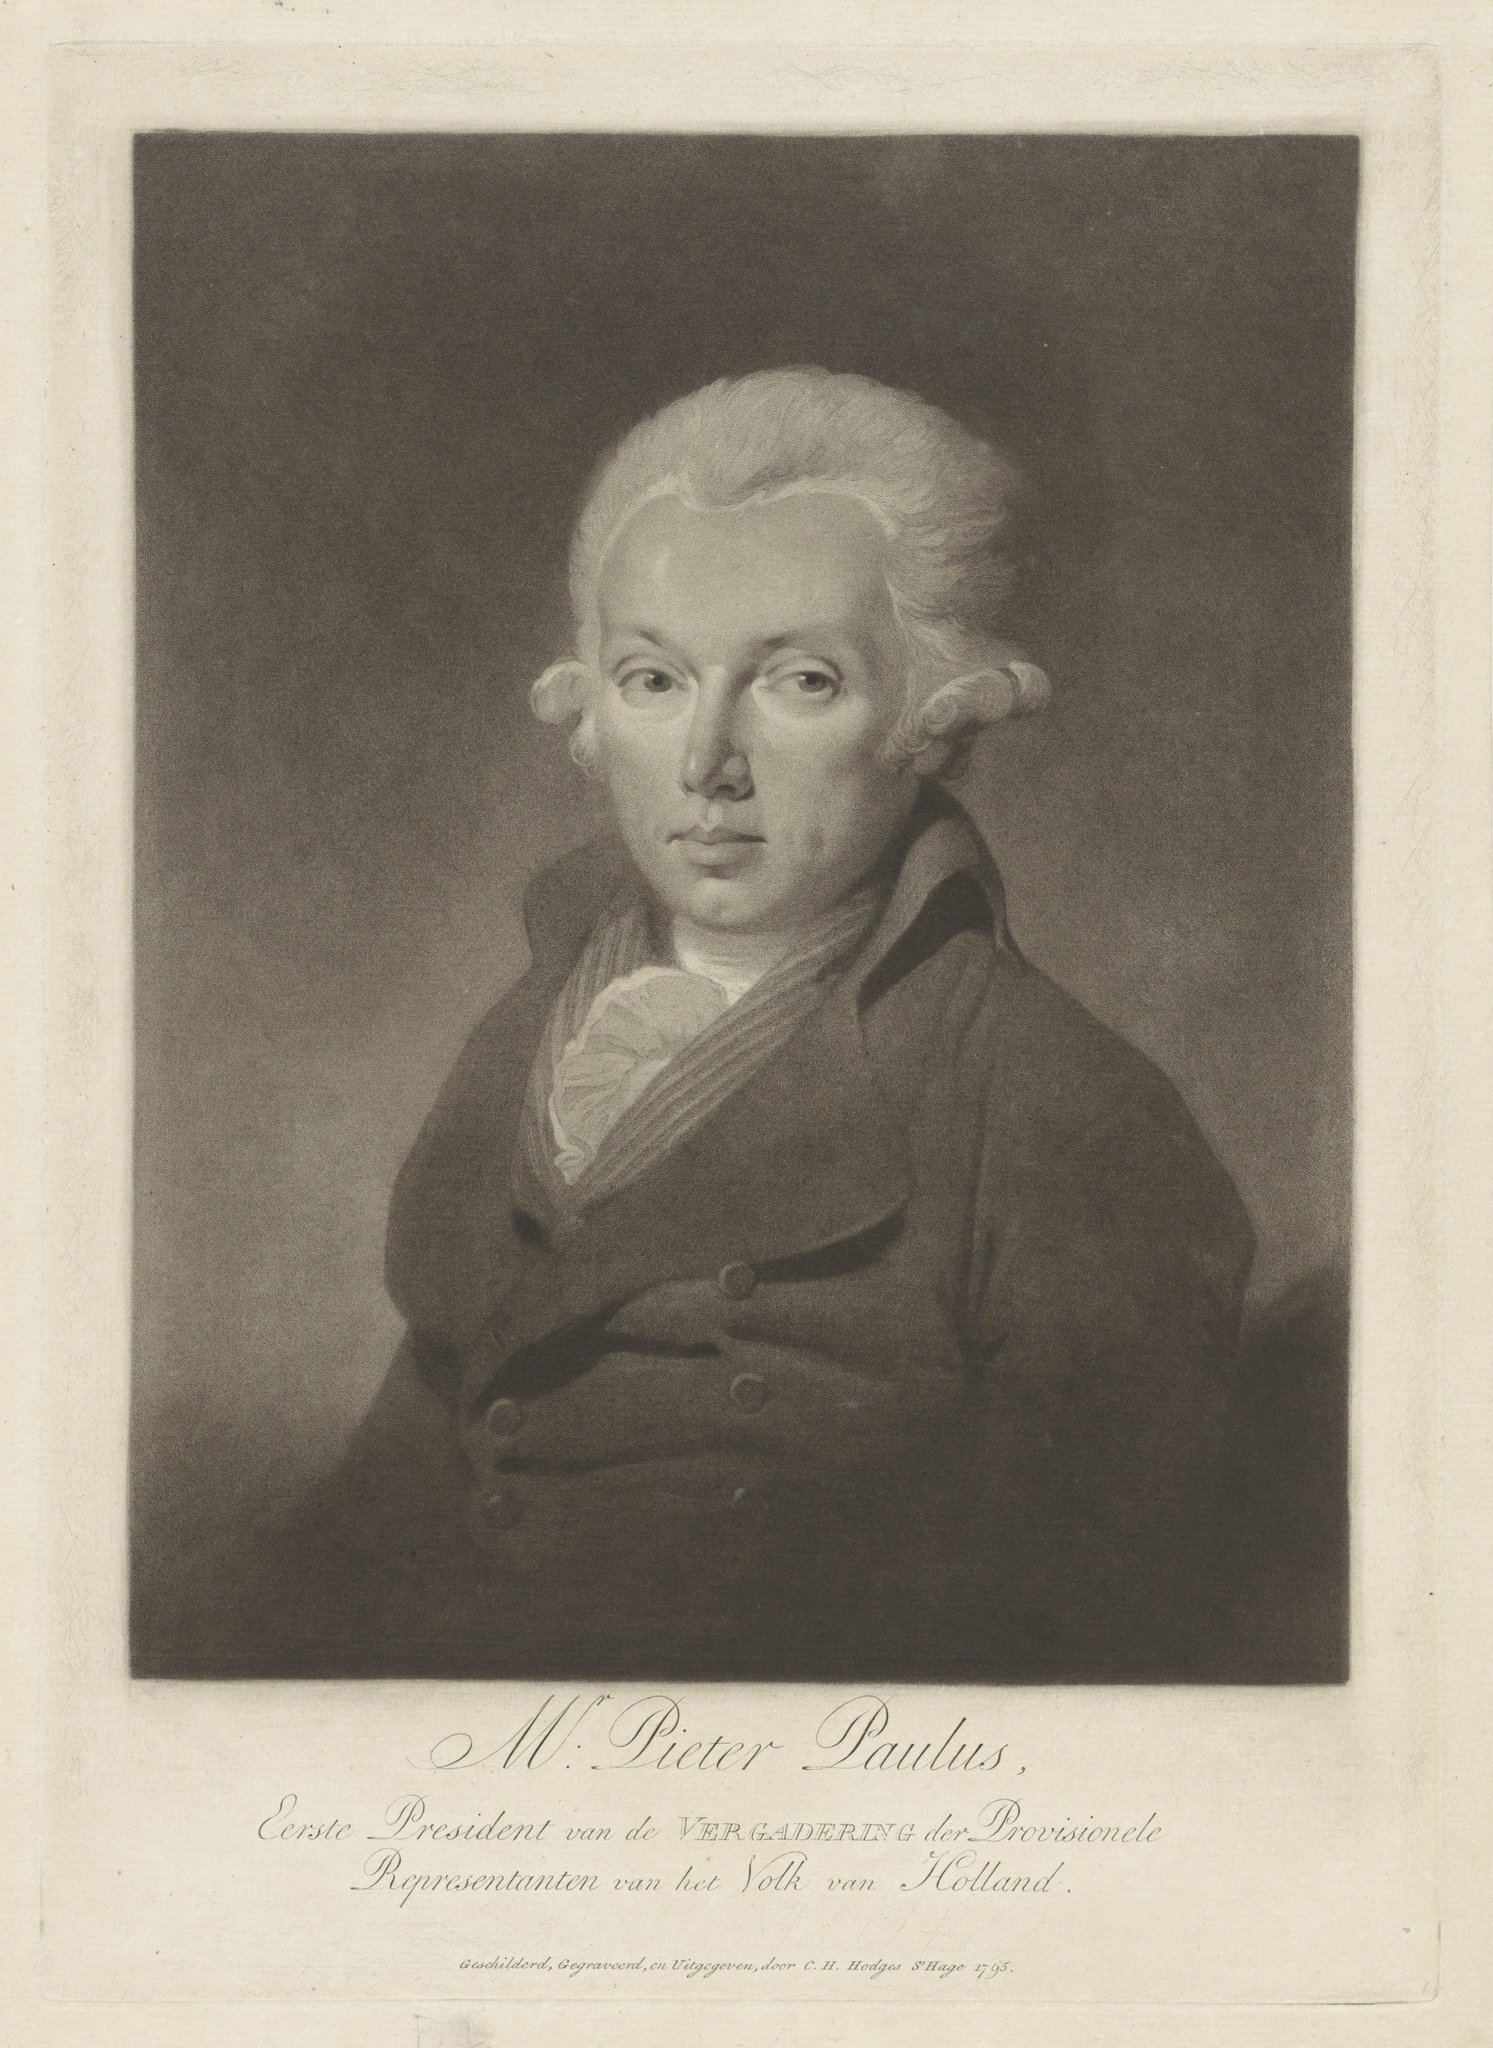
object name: print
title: Portret van Pieter Paulus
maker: charles howard hodges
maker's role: draughtsman, painter, print maker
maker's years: 1764-1837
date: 1795-1796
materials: paper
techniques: engraving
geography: the hague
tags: pieter paulus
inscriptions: collector's mark: Lugt 2228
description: Busteportret van de advocaat en politicus Pieter Paulus.